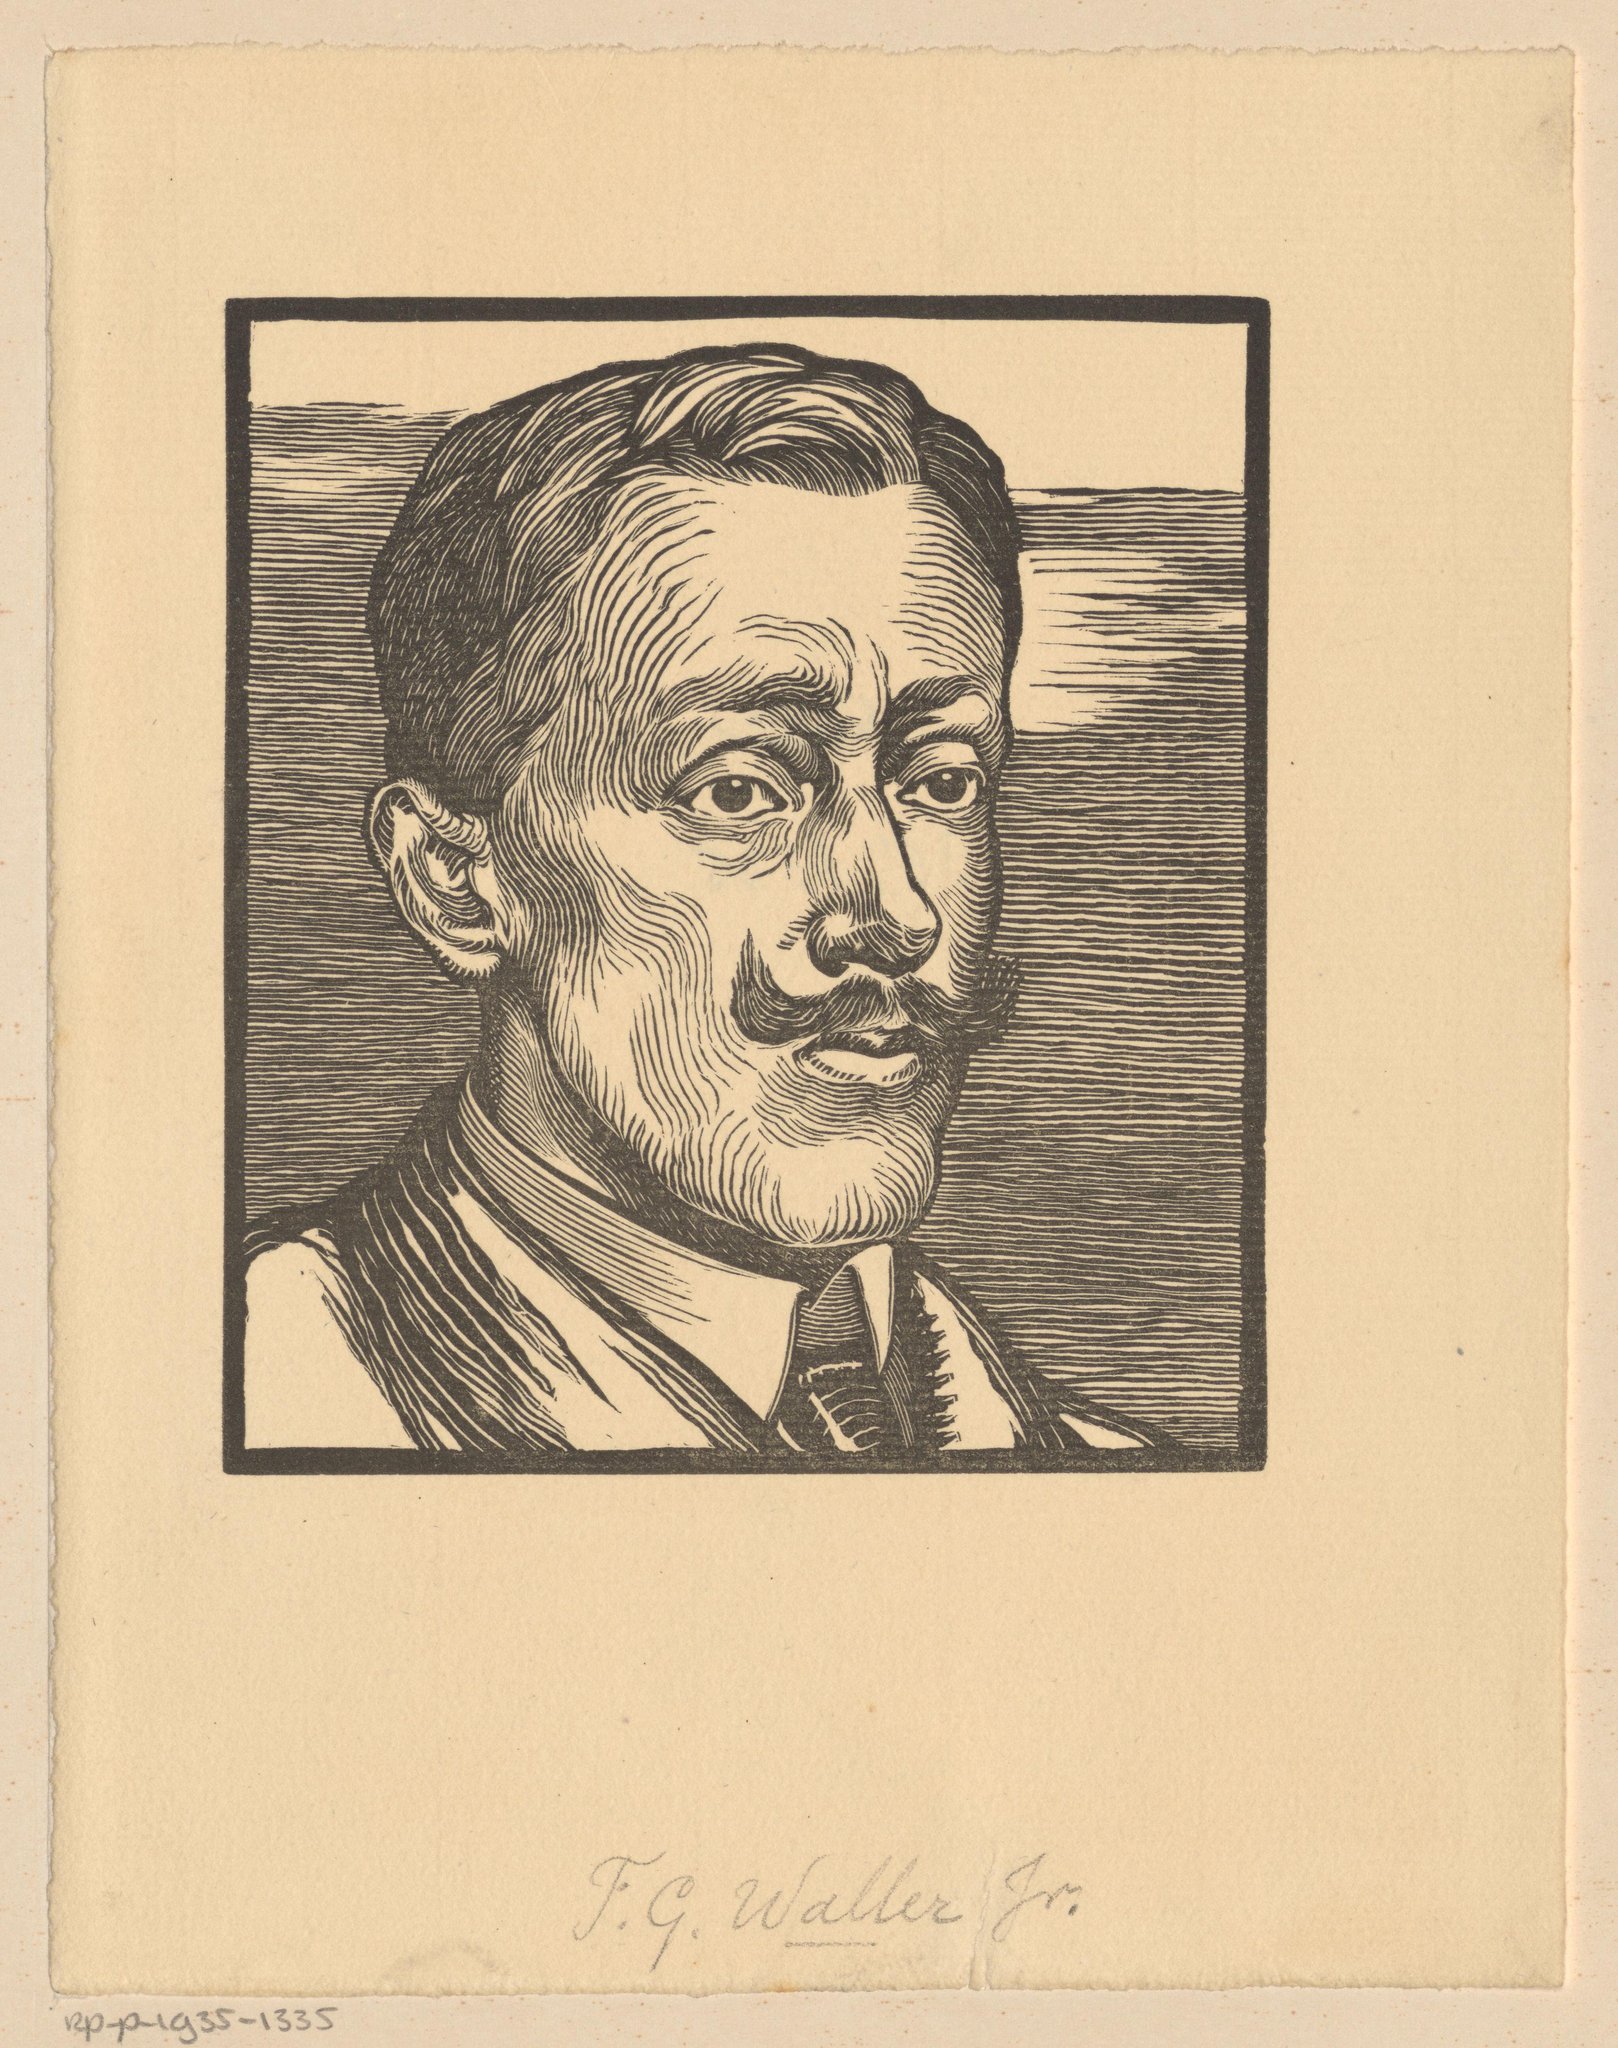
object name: print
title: Portret van François Gérard Waller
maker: johannes josephus aarts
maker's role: draughtsman, print maker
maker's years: 1871-1934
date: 1881-1934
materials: paper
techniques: woodcut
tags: historical persons, art collector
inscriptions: collector's mark: Lugt 2228